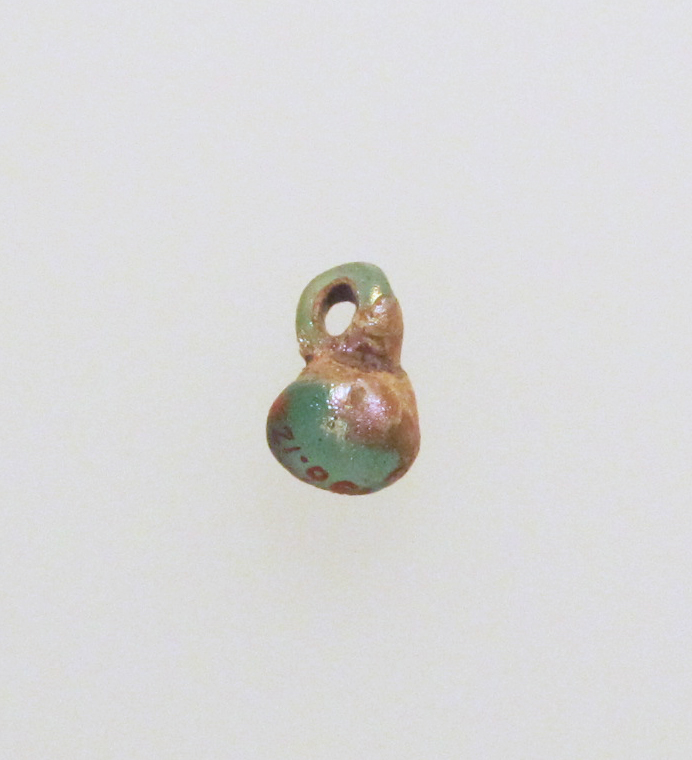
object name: pendant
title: Glass pendant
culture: roman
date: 101-300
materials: glass